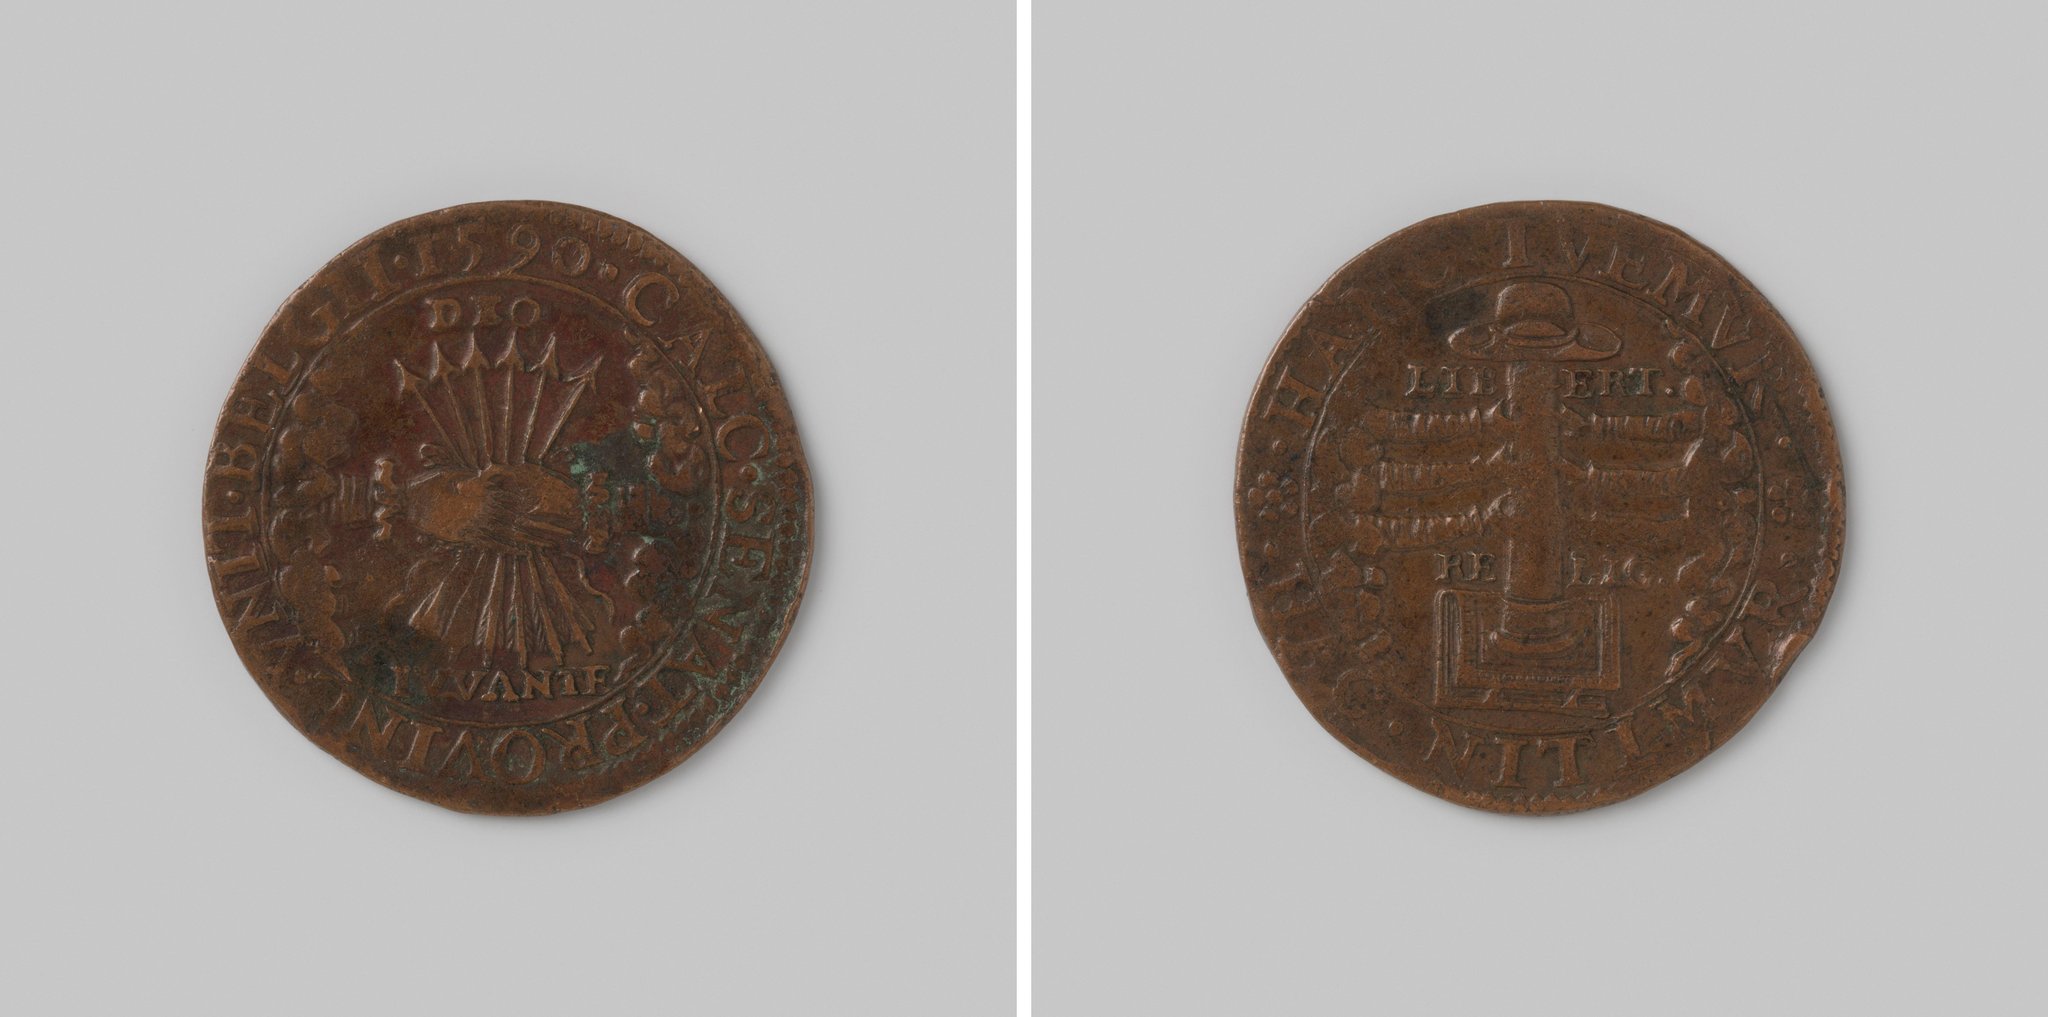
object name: jeton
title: Rekenpenning uit Dordrecht voor de Staten Generaal op de benoeming van Prins Maurits tot stadhouder 1590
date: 1590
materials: copper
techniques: striking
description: Koperen penning, op de voorzijde twee ineengeslagen handen boven een pijlenbundel, met tekst in het veld en omschrift, op de keerzijde zes handen die een zuil omvatten waarop een vrijheidshoed en staand op een bijbel, met tekst in het veld en omschrift.